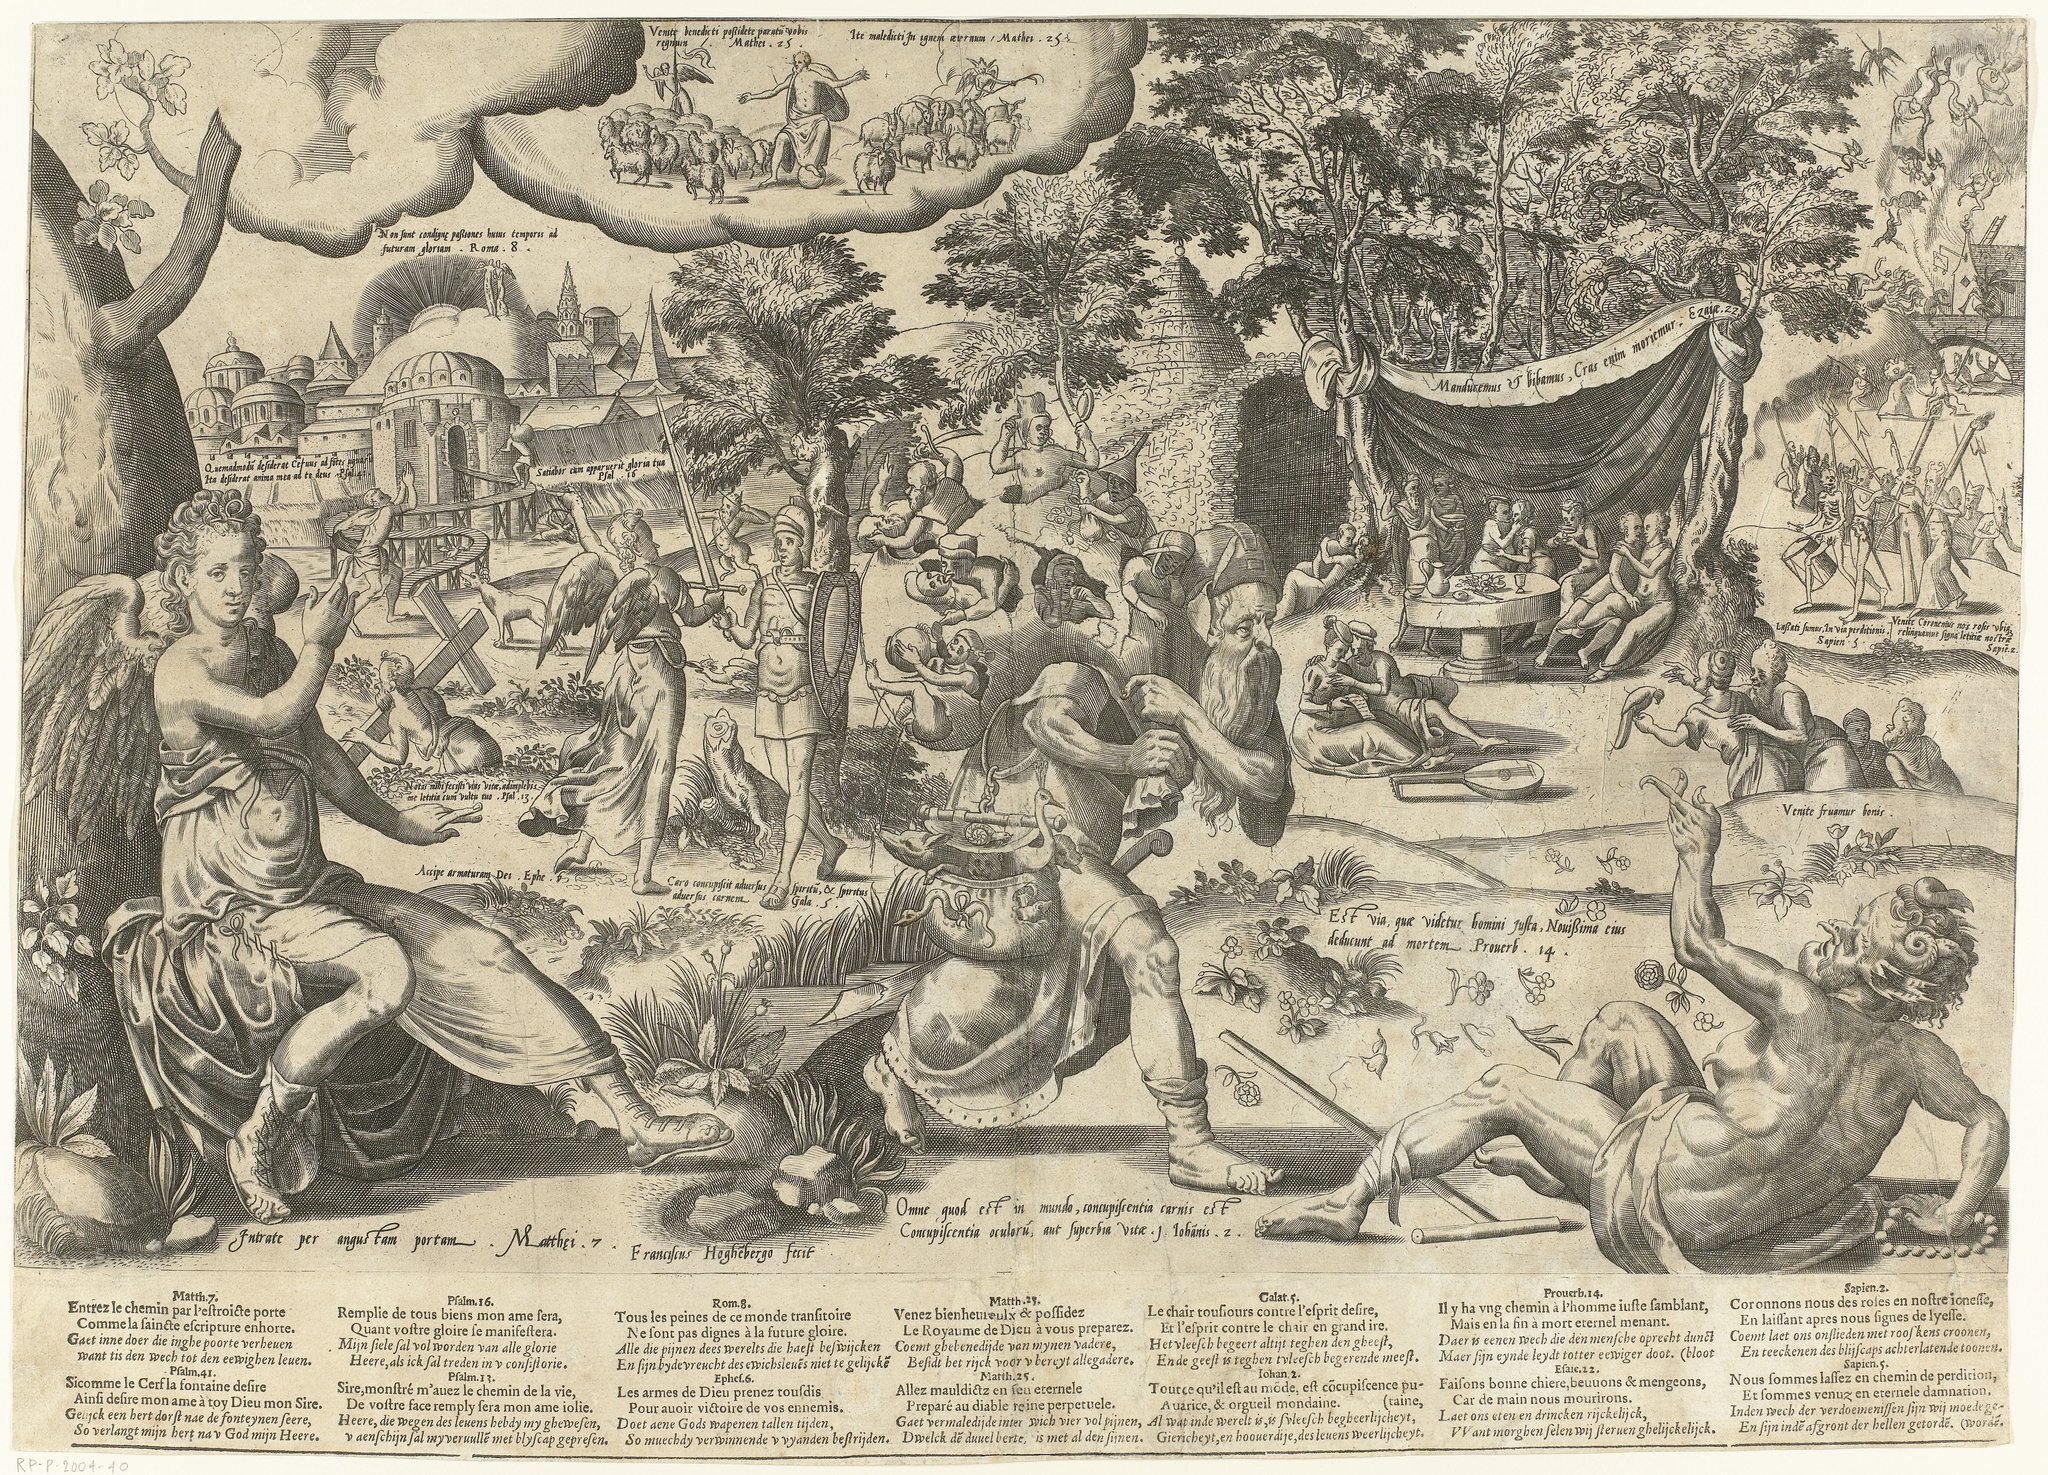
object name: print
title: De brede en de smalle weg: allegorie op de menselijke levensloop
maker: frans hogenberg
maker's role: print maker, publisher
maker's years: 1538-1590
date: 1540-1590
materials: paper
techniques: engraving, etching, letterpress printing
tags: 'sapientia' and the seven virtues, i.e. the three theological and the four cardinal virtues, crutches, disabilities, deformations, vice, and the seven deadly sins, the way to destruction is broad and the gate is wide; the way to life is narrow and the gate is straight ~ doctrine of christ on love, etc. (matthew 7:13-14; luke 13:24)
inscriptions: collector's mark: Lugt 2228, signature: ‘Franciscus Hogenbergo fecit’, collector's mark: Lugt 2760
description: Linksvoor een zittende engel, wijzend naar het hemels Jeruzalem achter hem. De smalle weg leidt ernaartoe. Rechtsvoor wijst een bedelend figuur met duivelskop die naast zijn krukken zit, naar de brede weg waarop een feestend en minnend gezelschap onder een baldakijn. Daarachter de hel. In het midden op de voorgrond loopt een oude man met een zak op zijn schouder gevuld met ondeugden: vleselijke begeerte, gierigheid, hovaardij. Middenboven in een wolk Christus die de goede en de kwade schapen scheidt.